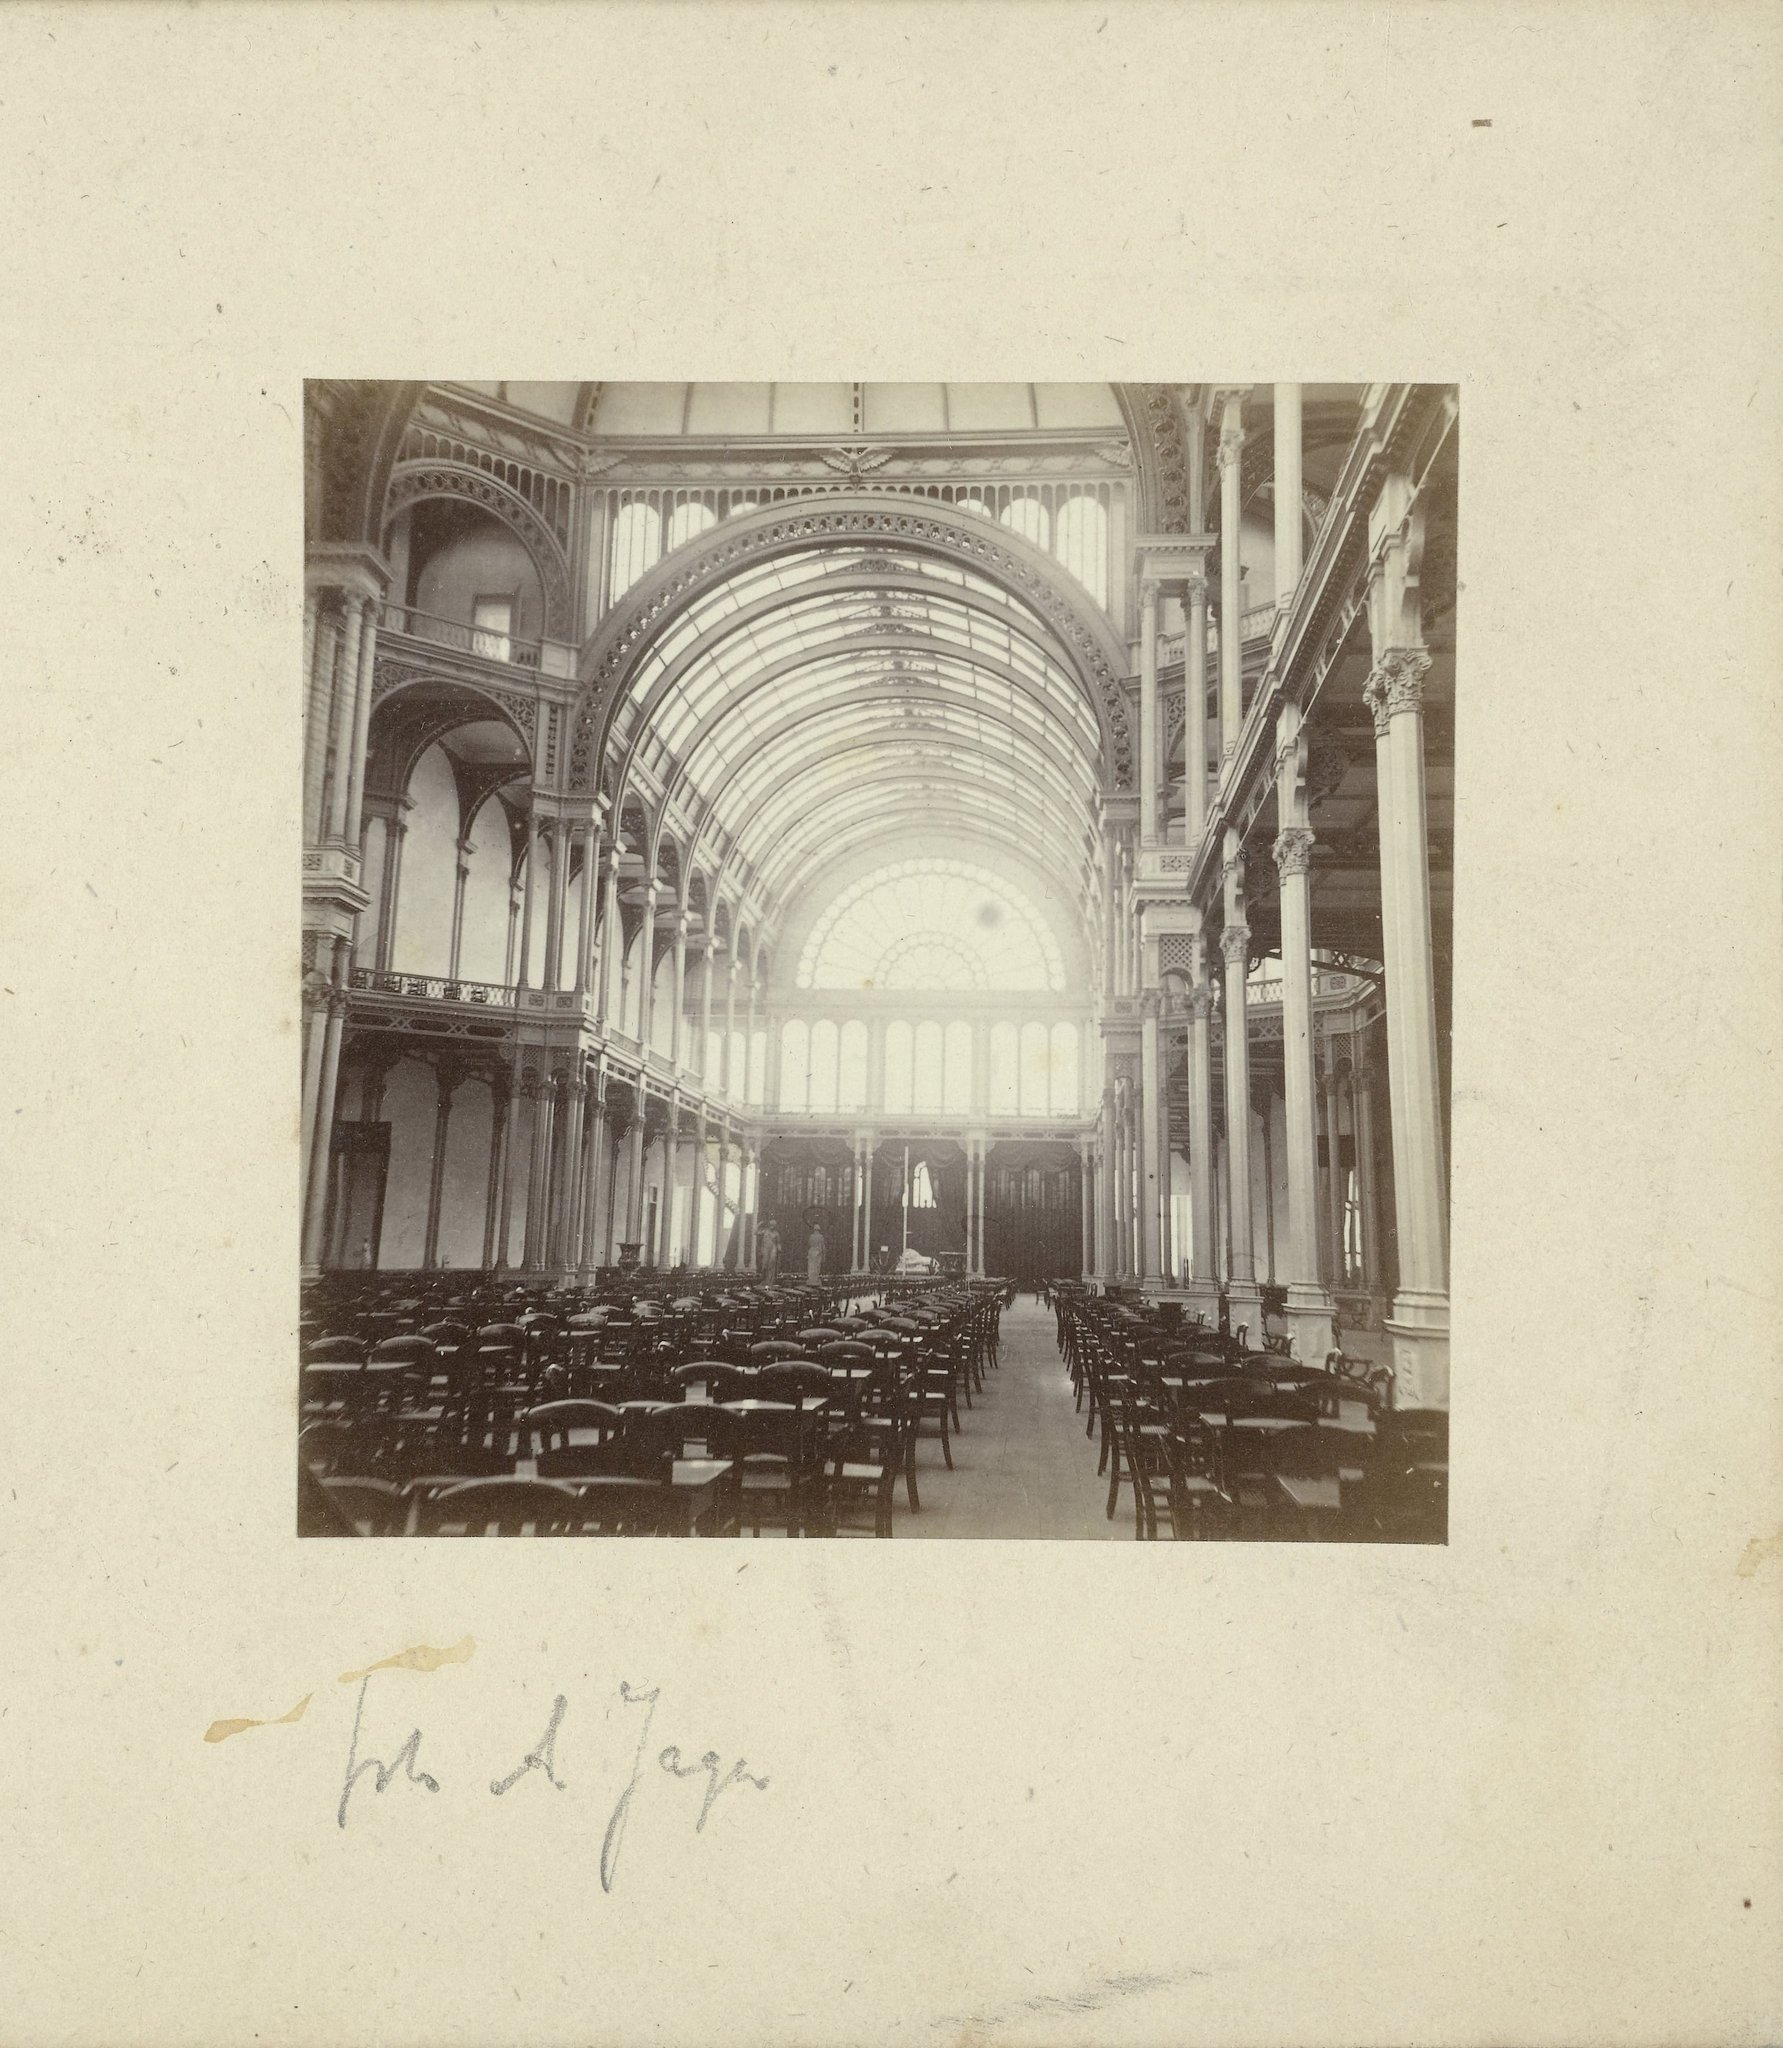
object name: photograph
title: Het paleis voor Volksvlijt inwendig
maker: andries jager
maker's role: publisher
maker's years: 1825-1905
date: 1864-1875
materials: cardboard, paper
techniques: albumen print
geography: amsterdam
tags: permanent exhibition, museum